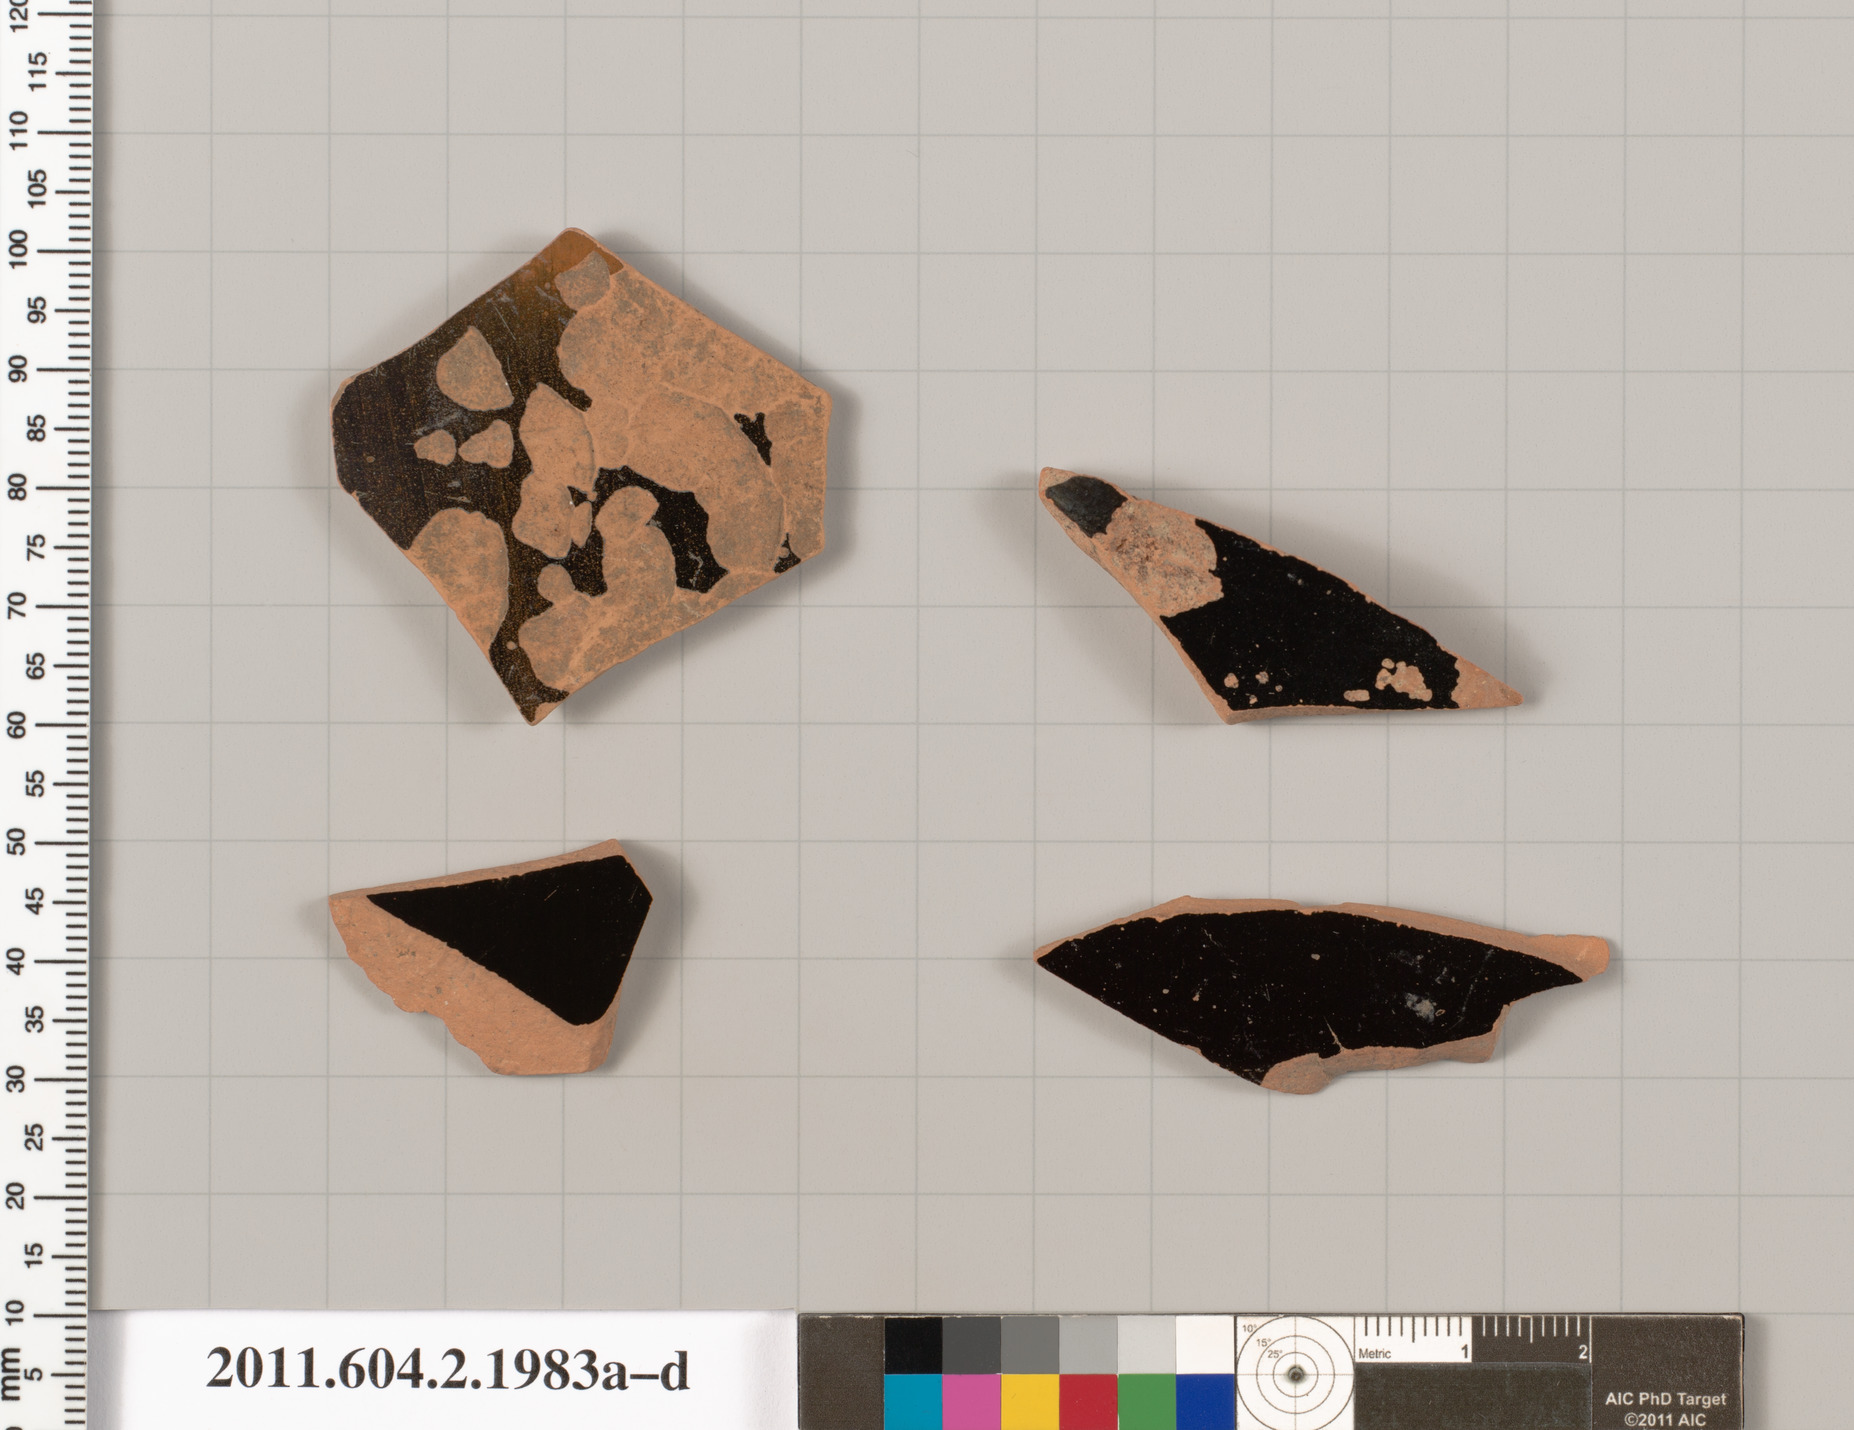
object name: pot fragment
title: Terracotta fragments of pots; unglazed on the inside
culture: greek, attic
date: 500-401 BCE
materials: terracotta